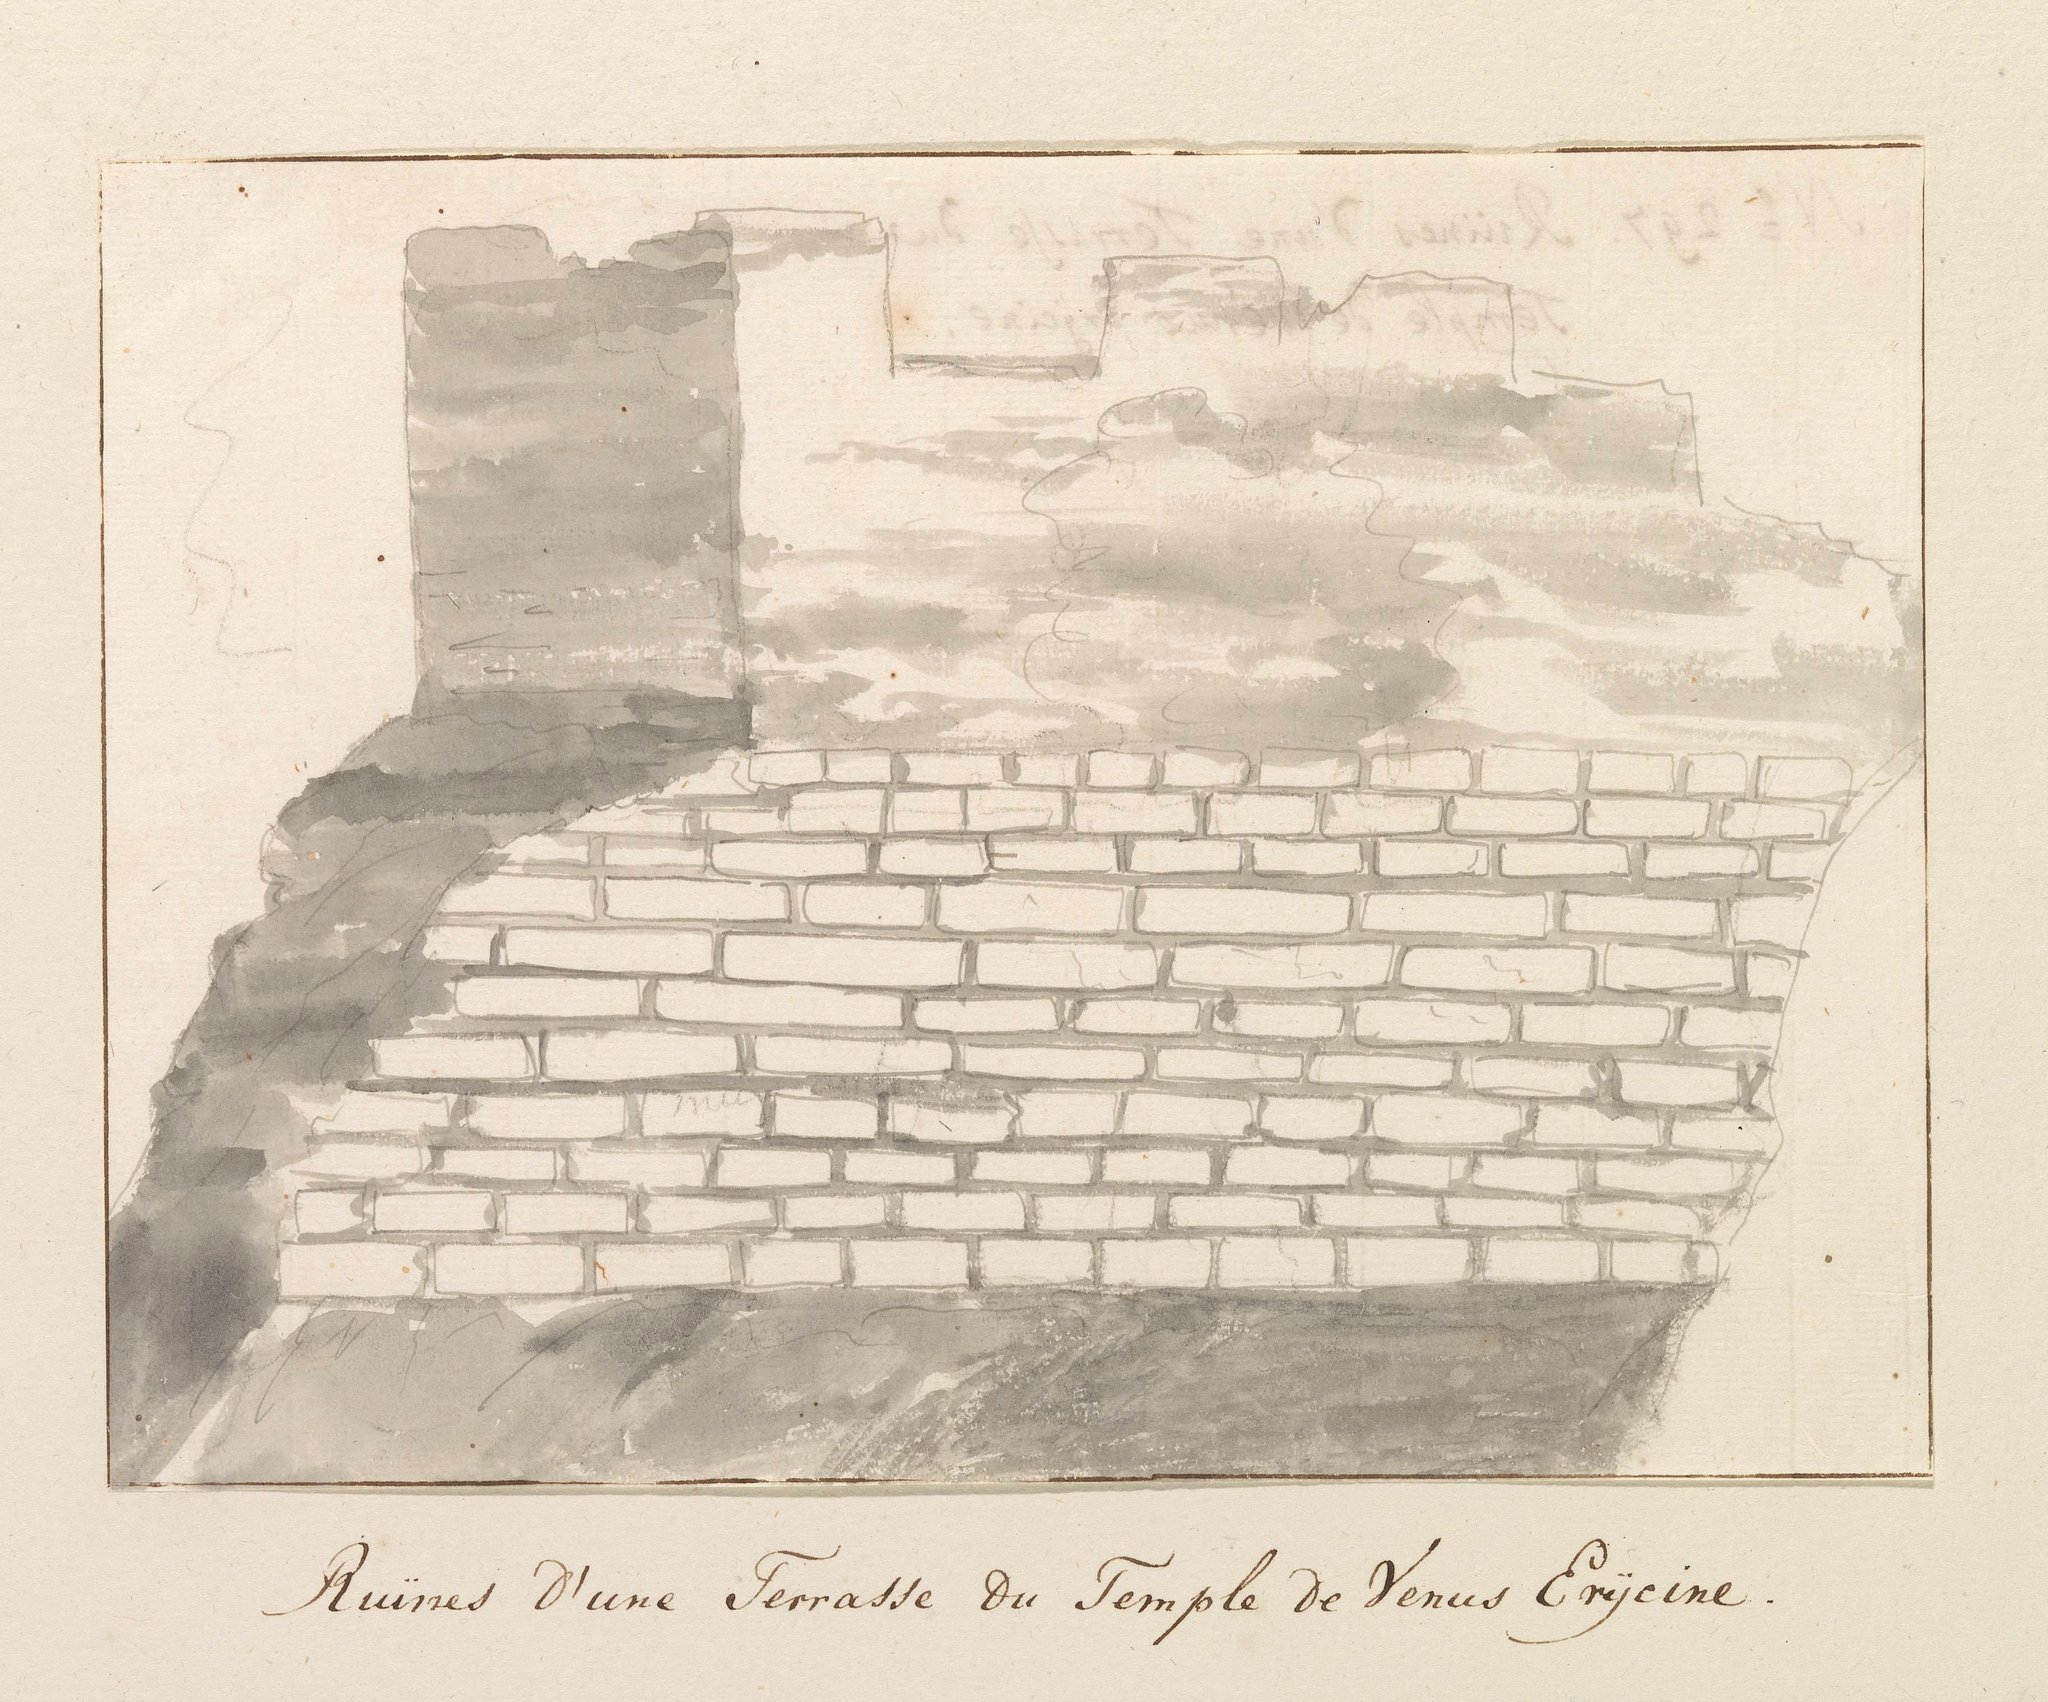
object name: drawing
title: Ruïne van terras van Venus tempel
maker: louis ducros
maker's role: draughtsman, print maker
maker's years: 1748-1810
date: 1778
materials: chalk, paper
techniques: brush, pen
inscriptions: inscription: ‘No 297 Ruïnes d'une Terrasse du Temple de Venus Erycine’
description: Tekening uit het album 'Voyage en Italie, en Sicile et à Malte', 1778.